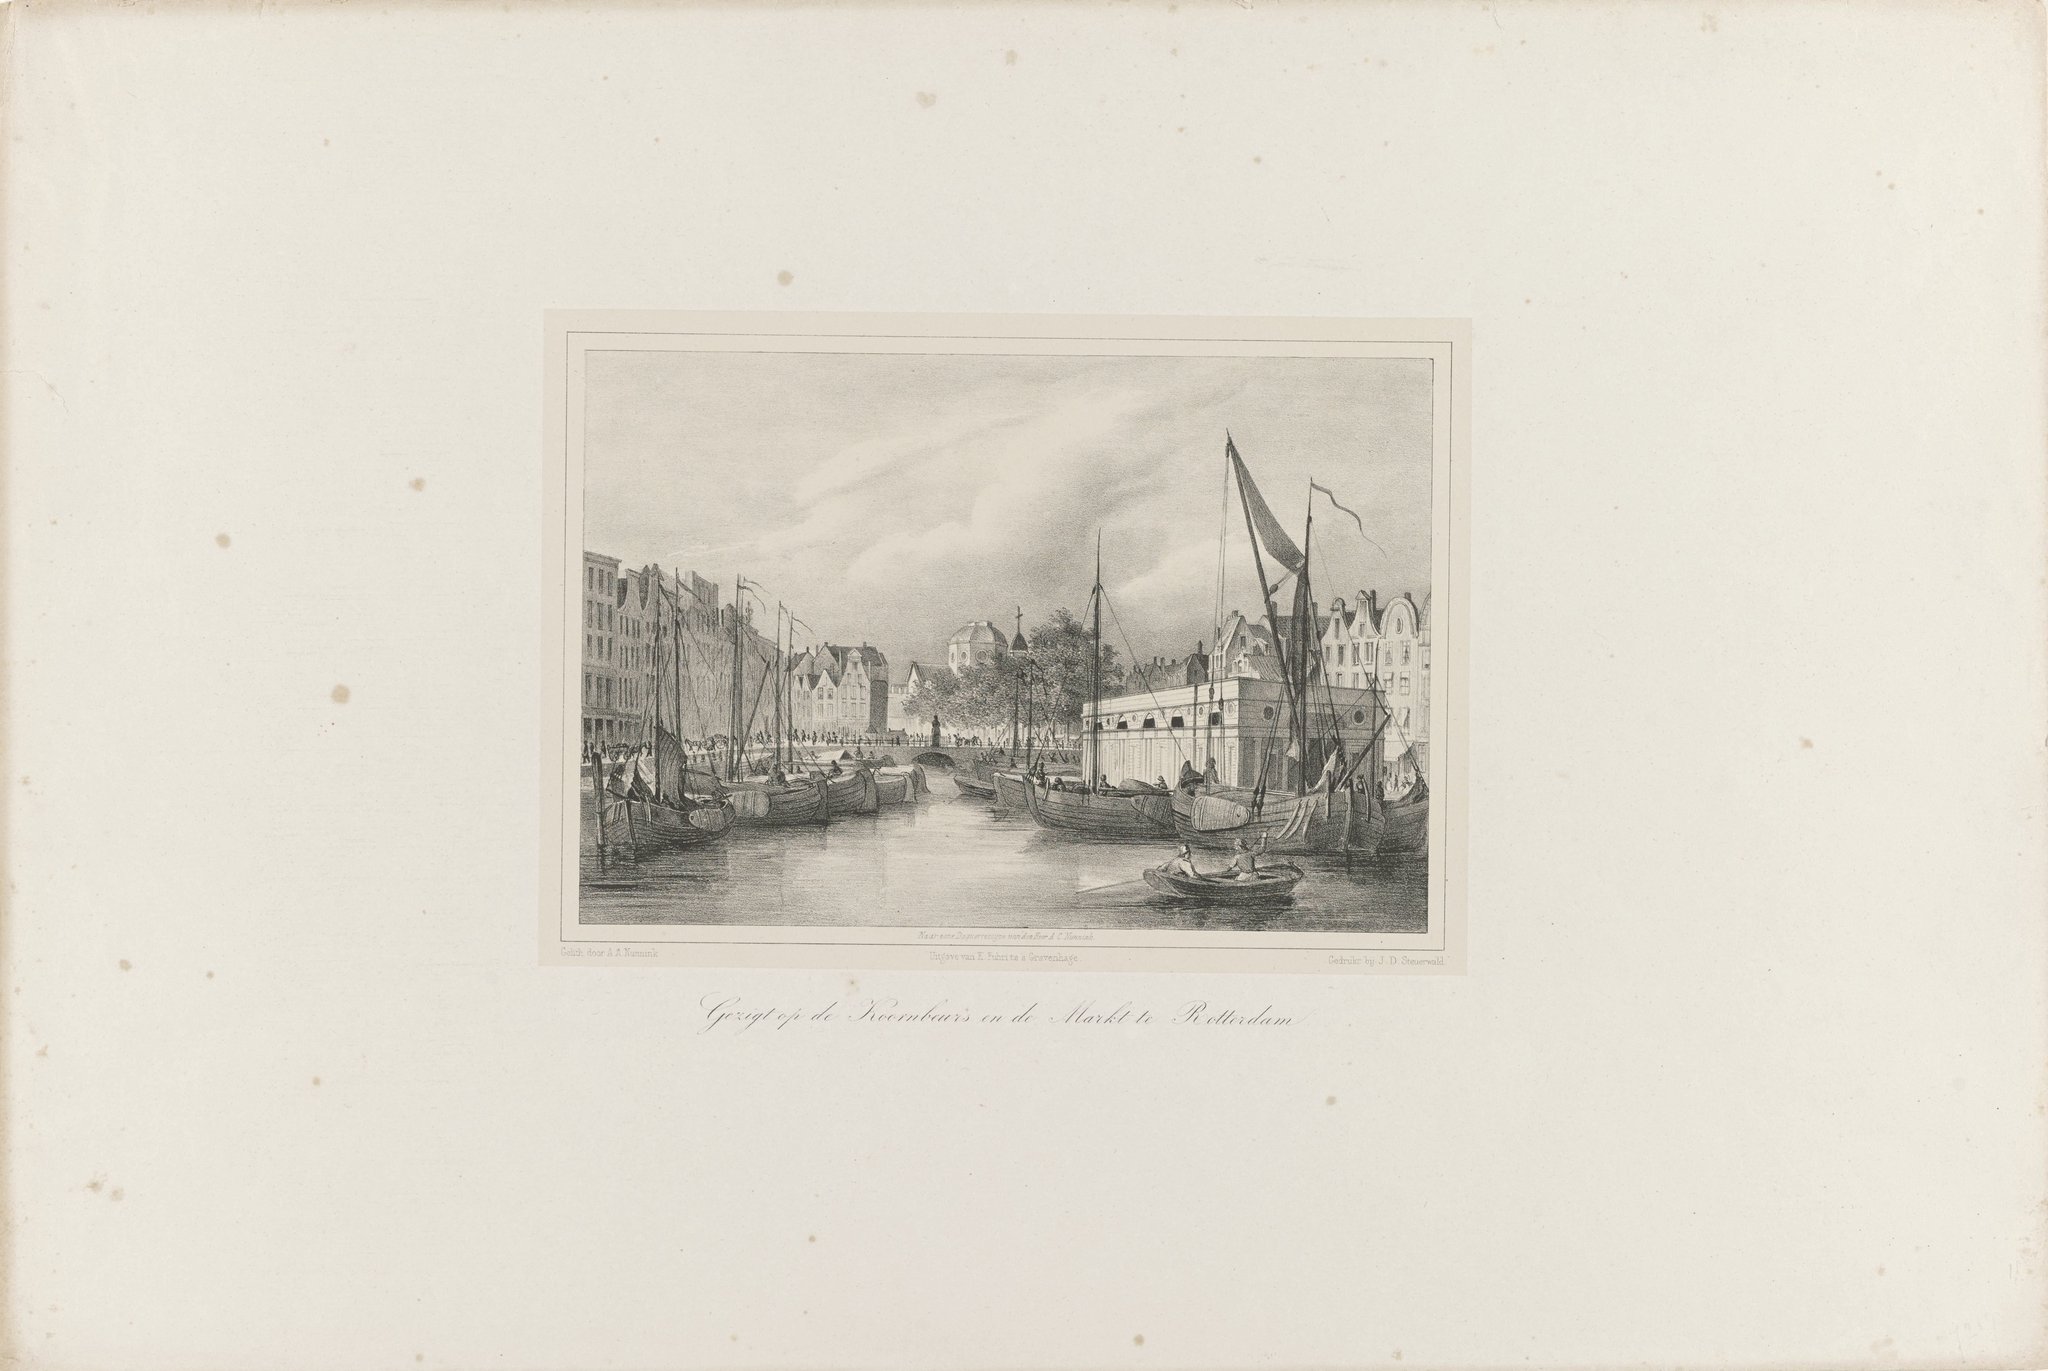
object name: print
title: Gezigt op de Koornbeurs en de Markt te Rotterdam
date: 1855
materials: paper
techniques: lithograph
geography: rotterdam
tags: rotterdam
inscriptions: collector's mark: Lugt 2228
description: Gezicht op de Korenbeurs te Rotterdam. Onderdeel van een serie van twaalf portretten naar daguerrotypieën en twaalf stadsgezichten. Ter gelegenheid van het Muziekfeest ter viering van het 25-jarige bestaan van de Maatschappij ter Bevordering van Toonkunst in Rotterdam, 12-15 juli 1854.